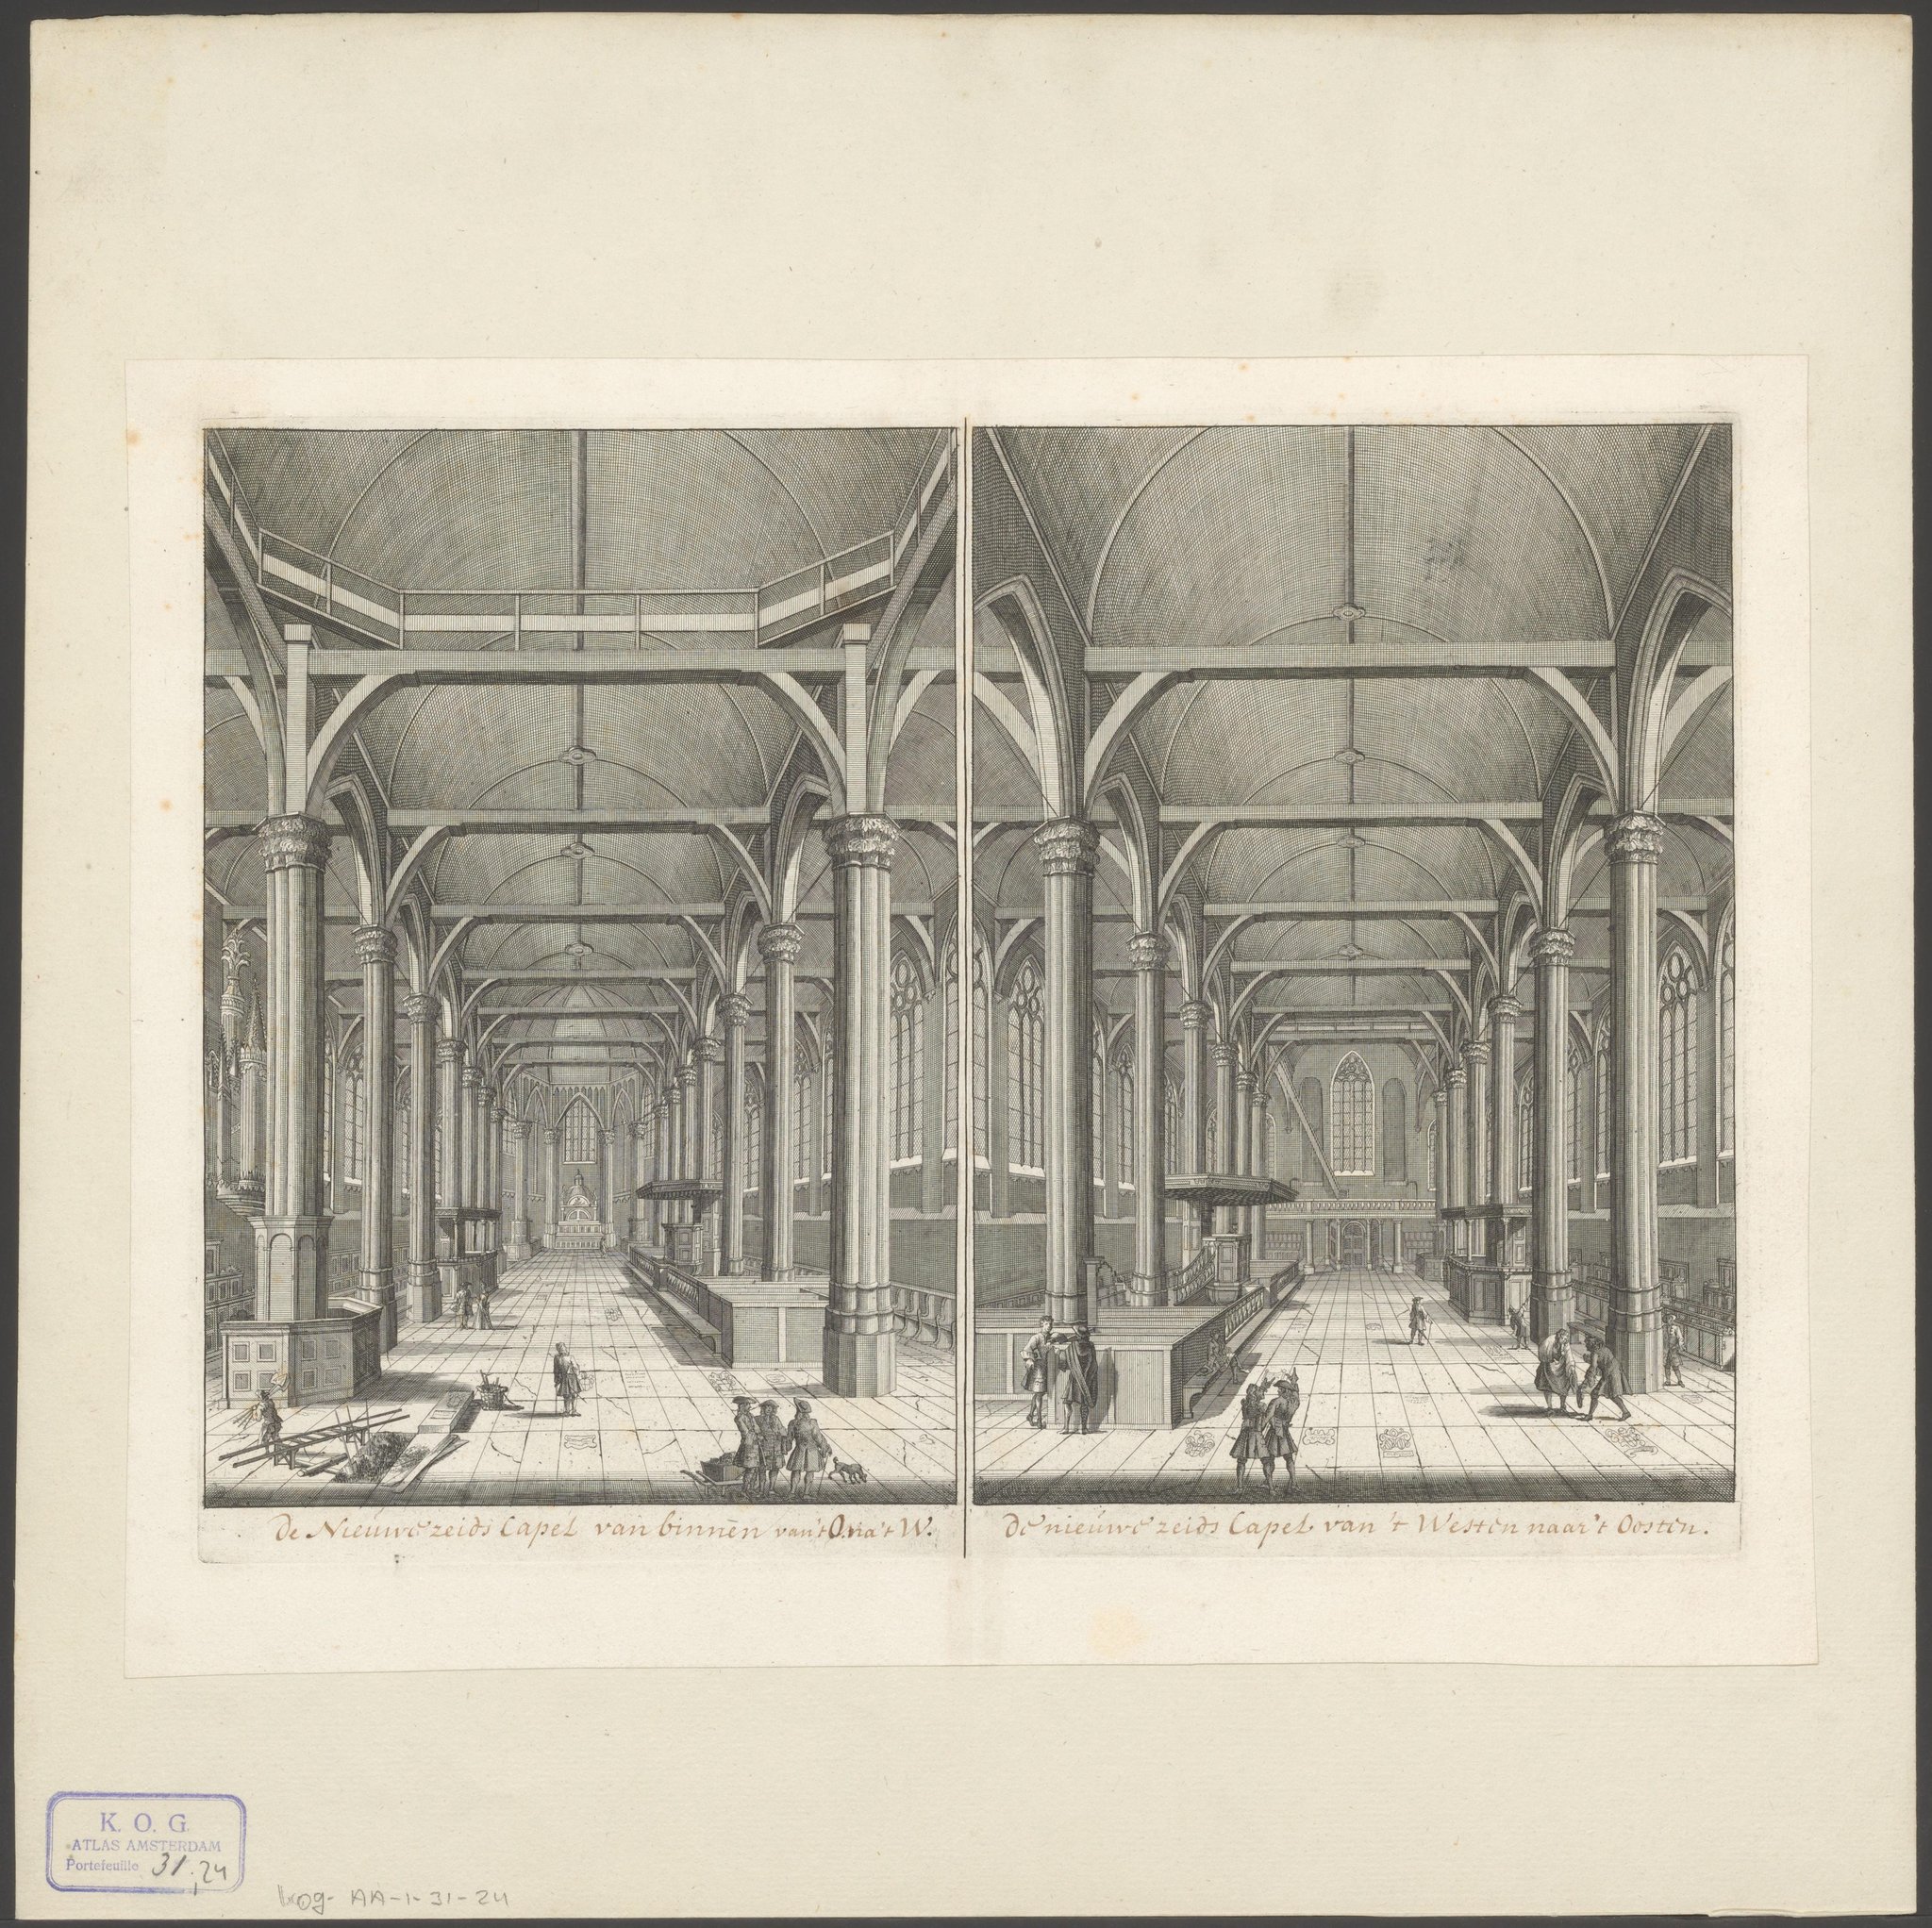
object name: print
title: Interieur van de Nieuwezijds Kapel te Amsterdam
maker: jan goeree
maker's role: draughtsman, print maker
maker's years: 1670-1731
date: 1680-1731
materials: paper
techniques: etching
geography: amsterdam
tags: interior of church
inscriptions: collector's mark: Lugt 1641b, title: ‘de Nieuwezeids Capel van binnen van 't O via 't W / de nieuwezeids Capel van 't Westen naar 't Oosten’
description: Latere staat, met tekst, gebruikt in: Wagenaar, Jan. Amsterdam, in zyne opkomst, aanwas, geschiedenissen (…). Amsterdam: Isaak Tirion, 1765, dl. 2. En in: Verzameling der fraaiste gezigten van Amsterdam in negen en zeventig afbeeldingen. Amsterdam en Harlingen: Petrus Conradi en Volkert van der Plaats, 1782.